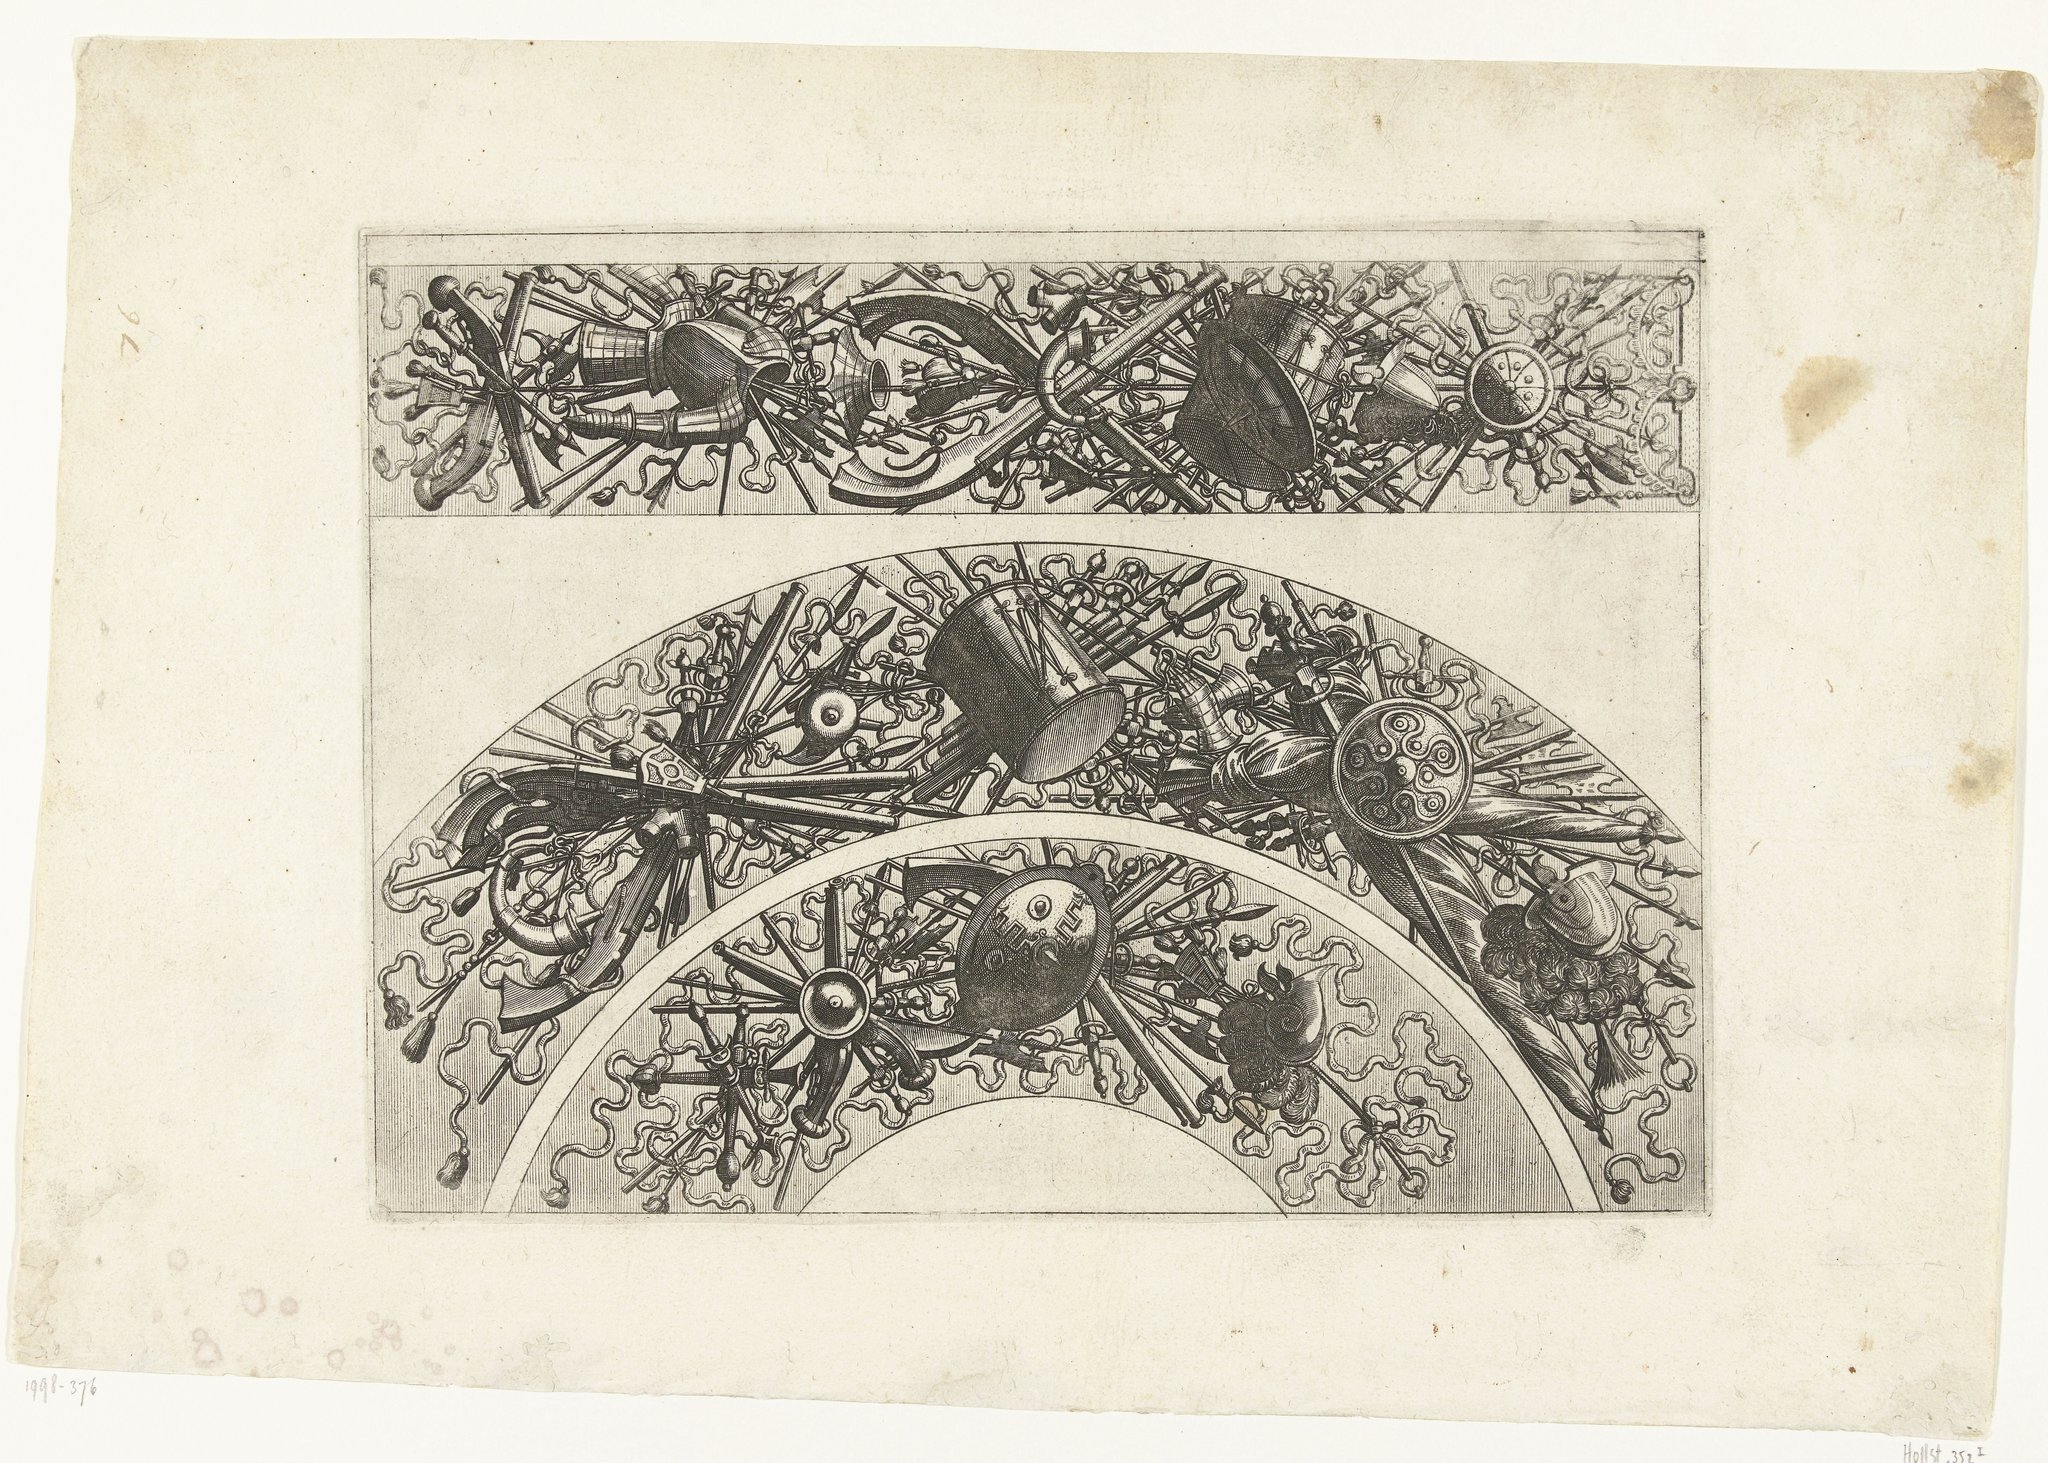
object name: print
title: Panoplia sev armamentarium…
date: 1572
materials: paper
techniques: etching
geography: netherlands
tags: musical instruments; group of musical instruments, trophy, i.e.: decorative arrangement of symbolic or typical objects ~ ornament, armour, weapons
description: Twee halve cirkelvormige randen met trofeeën van wapens en muziekinstrumenten, onder een horizontaal compartiment met trofee van harnassen en wapens. Uit serie, bestaande uit een titelblad en 16 bladen.